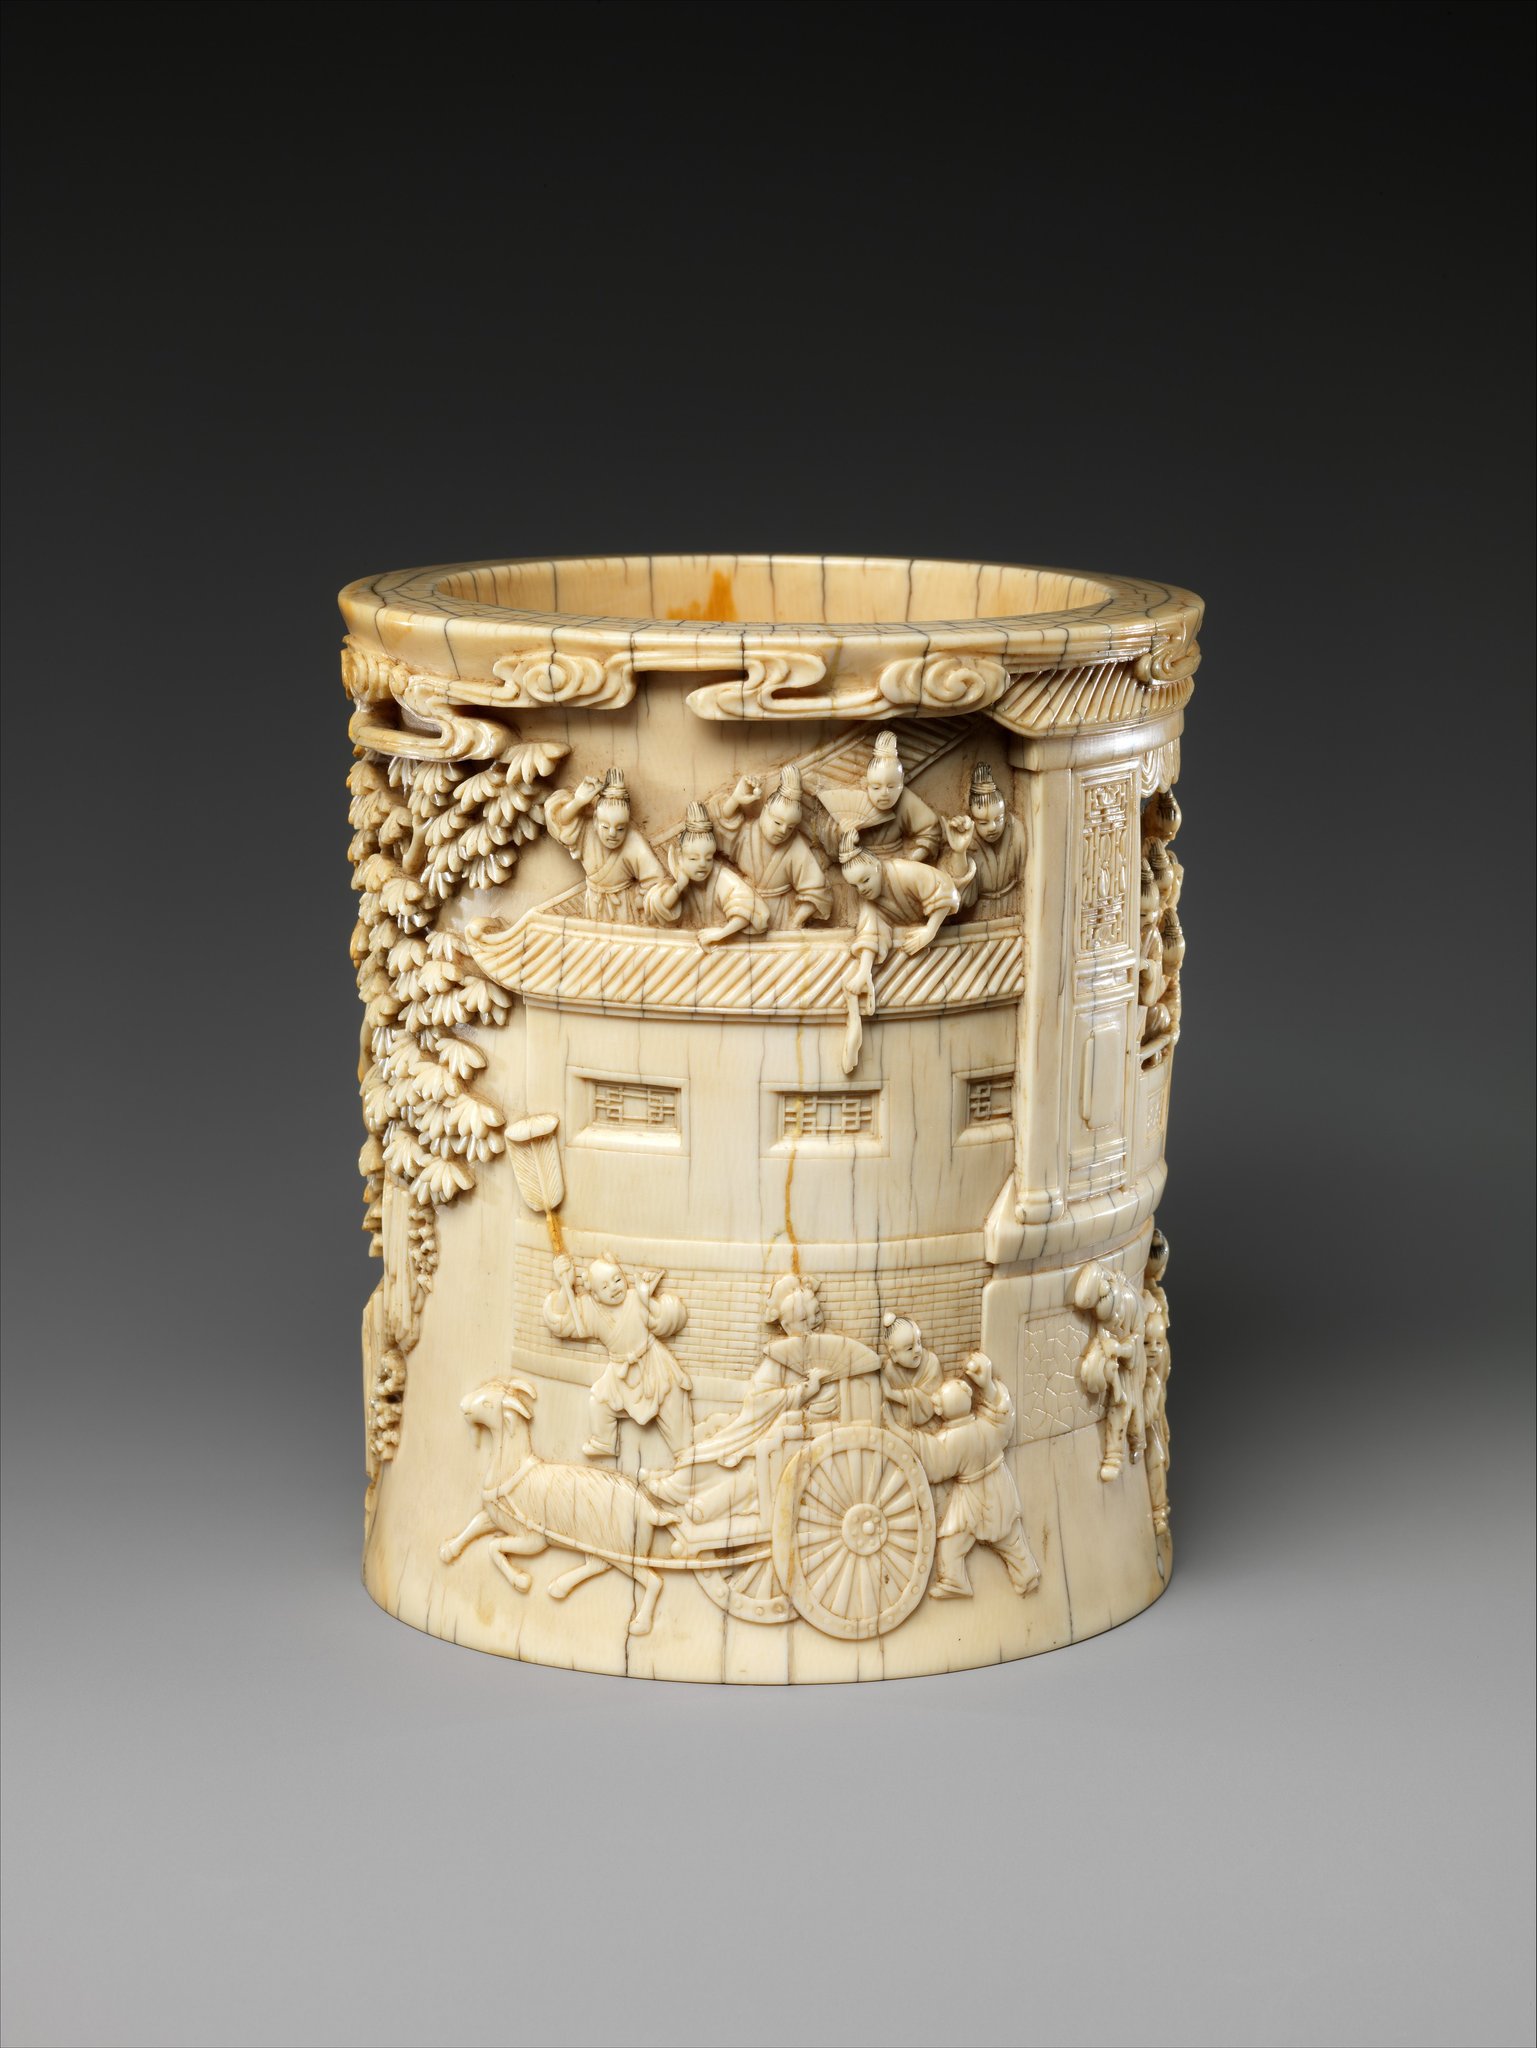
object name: brush holder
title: Brush holder with the story of Pan An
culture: chinese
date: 1701-1800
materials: ivory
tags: balconies,men,women,goats,carts